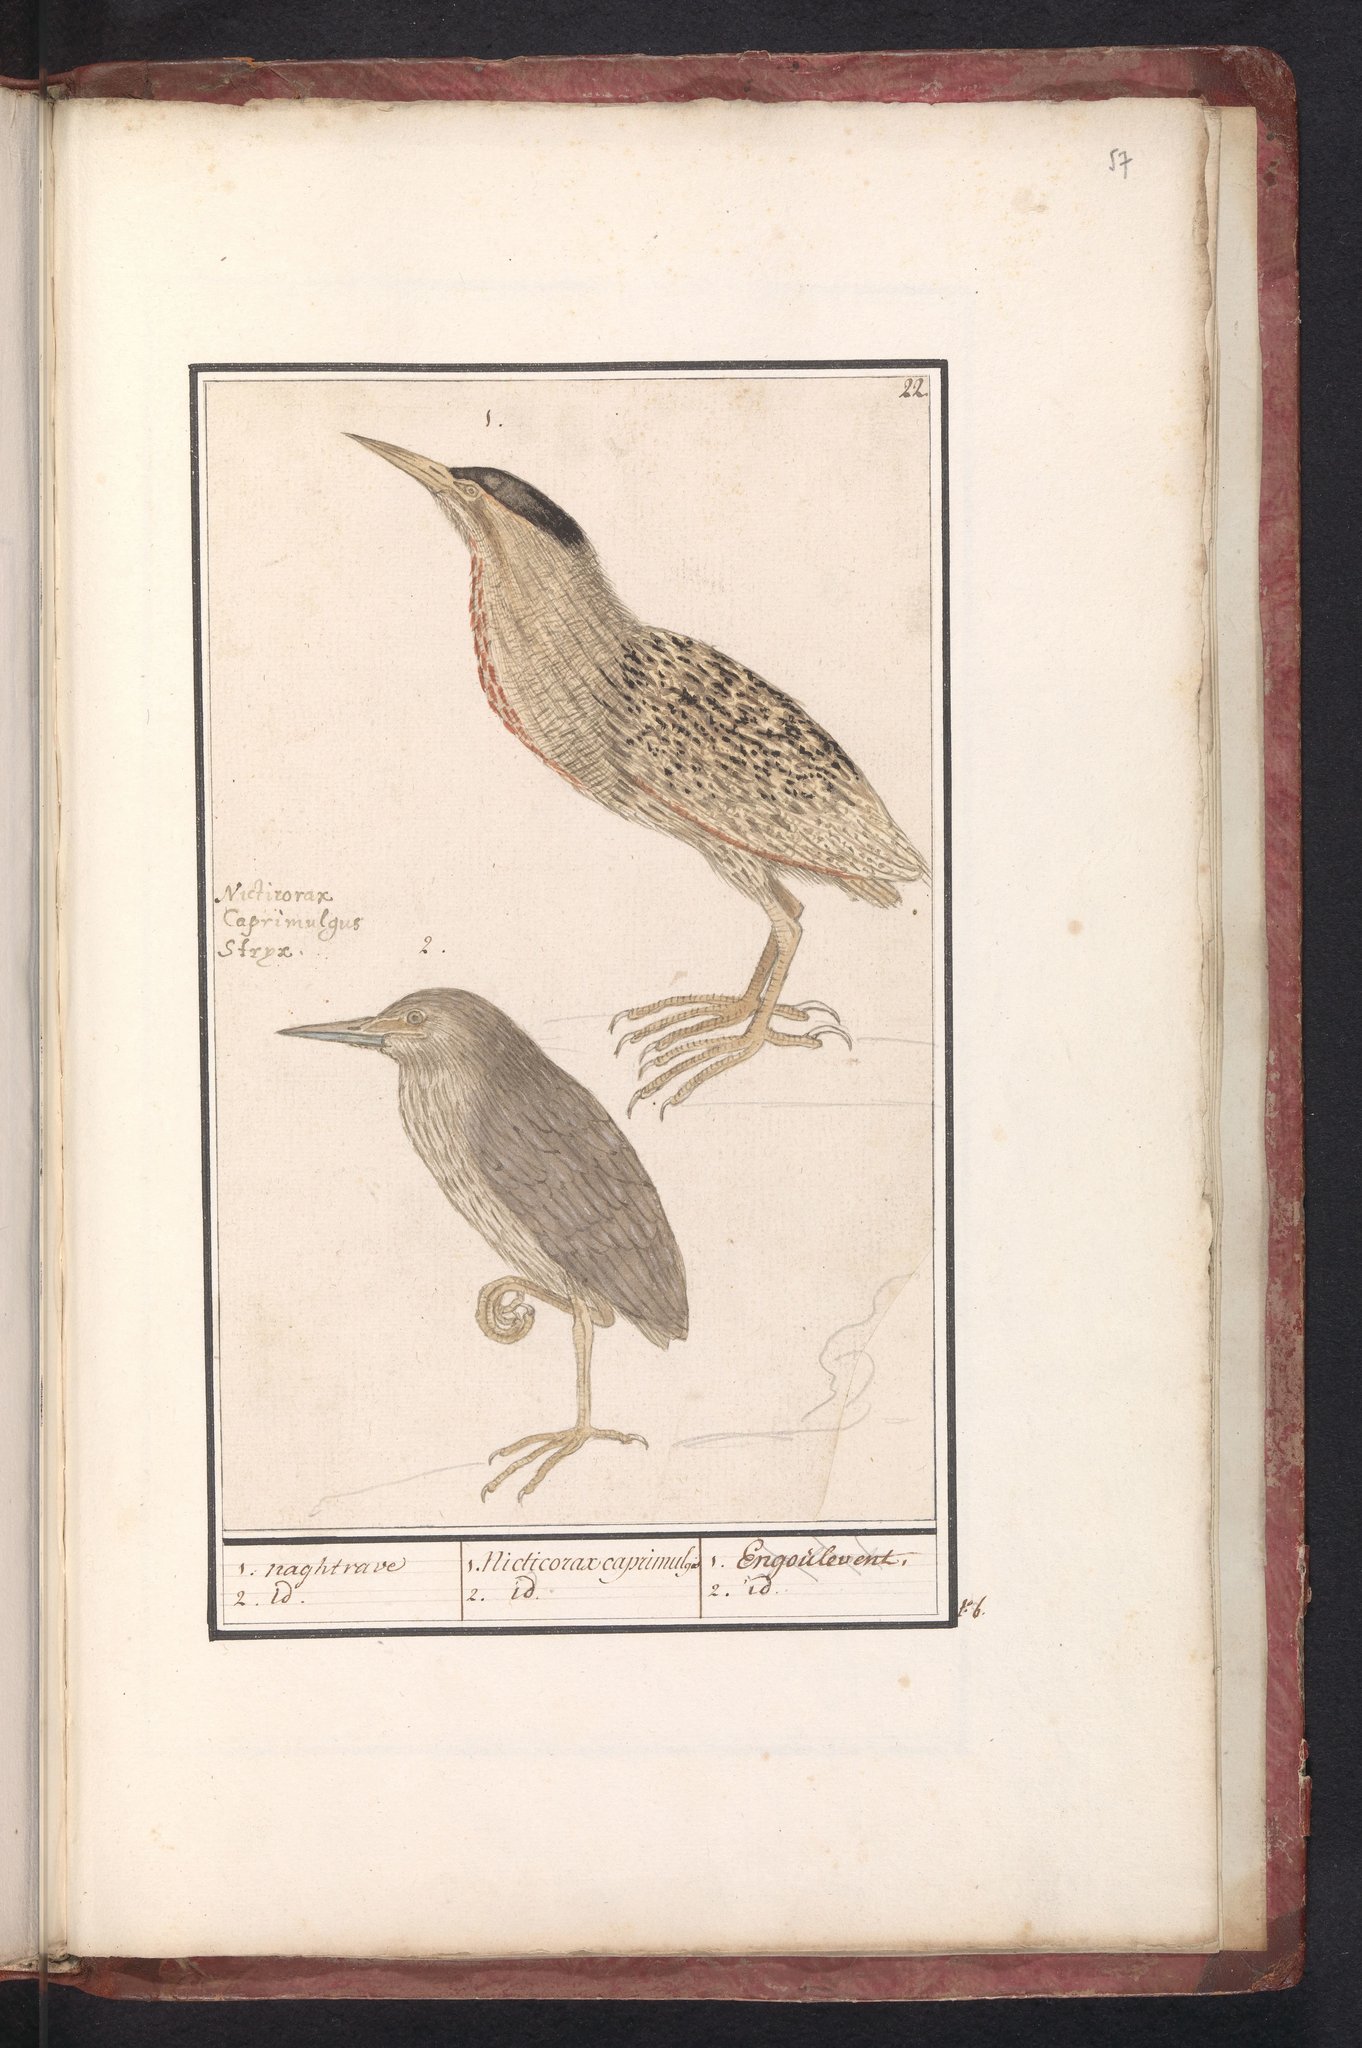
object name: drawing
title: Roerdomp (Botaurus stellaris)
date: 1596-1610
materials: paint, ink, paper, pencil, watercolor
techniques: brush, pen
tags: shore-birds and wading-birds: bittern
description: Roerdomp, twee keer. Genummerd rechtsboven: 22. Onderdeel van het tweede album met tekeningen van vogels. Vierde van twaalf albums met tekeningen van dieren, vogels en planten bekend rond 1600, gemaakt in opdracht van keizer Rudolf II. Met toelichting in Nederlands, Latijn en Frans.